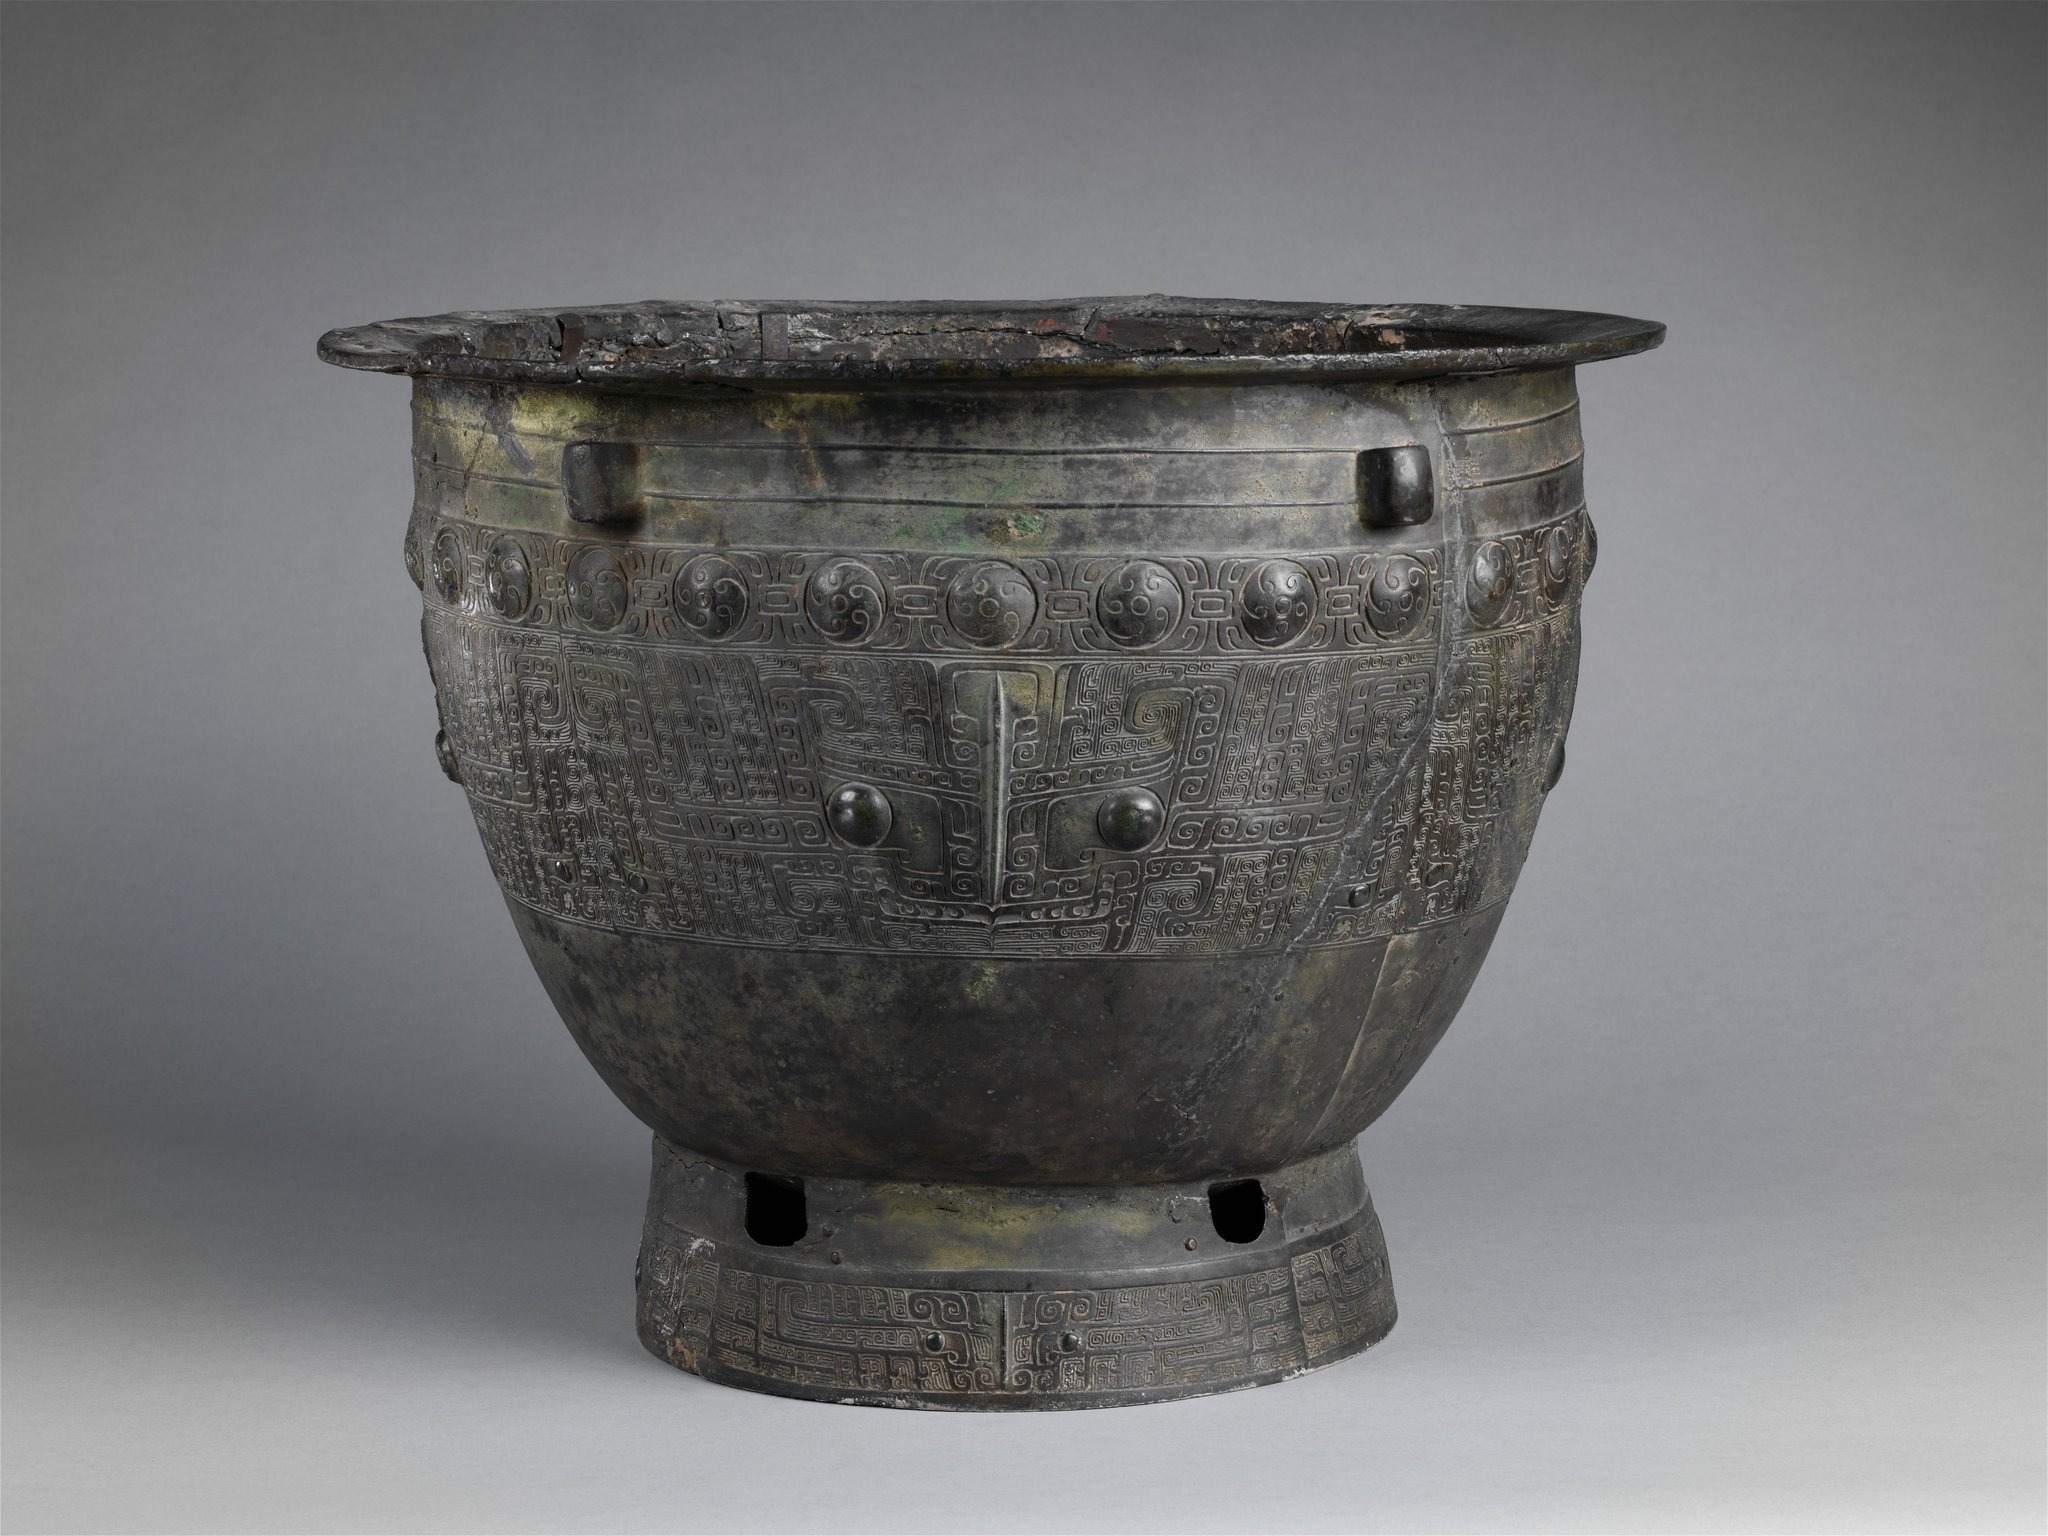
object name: food container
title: Food container (yu)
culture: chinese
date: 1200-1001 BCE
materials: bronze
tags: cauldrons